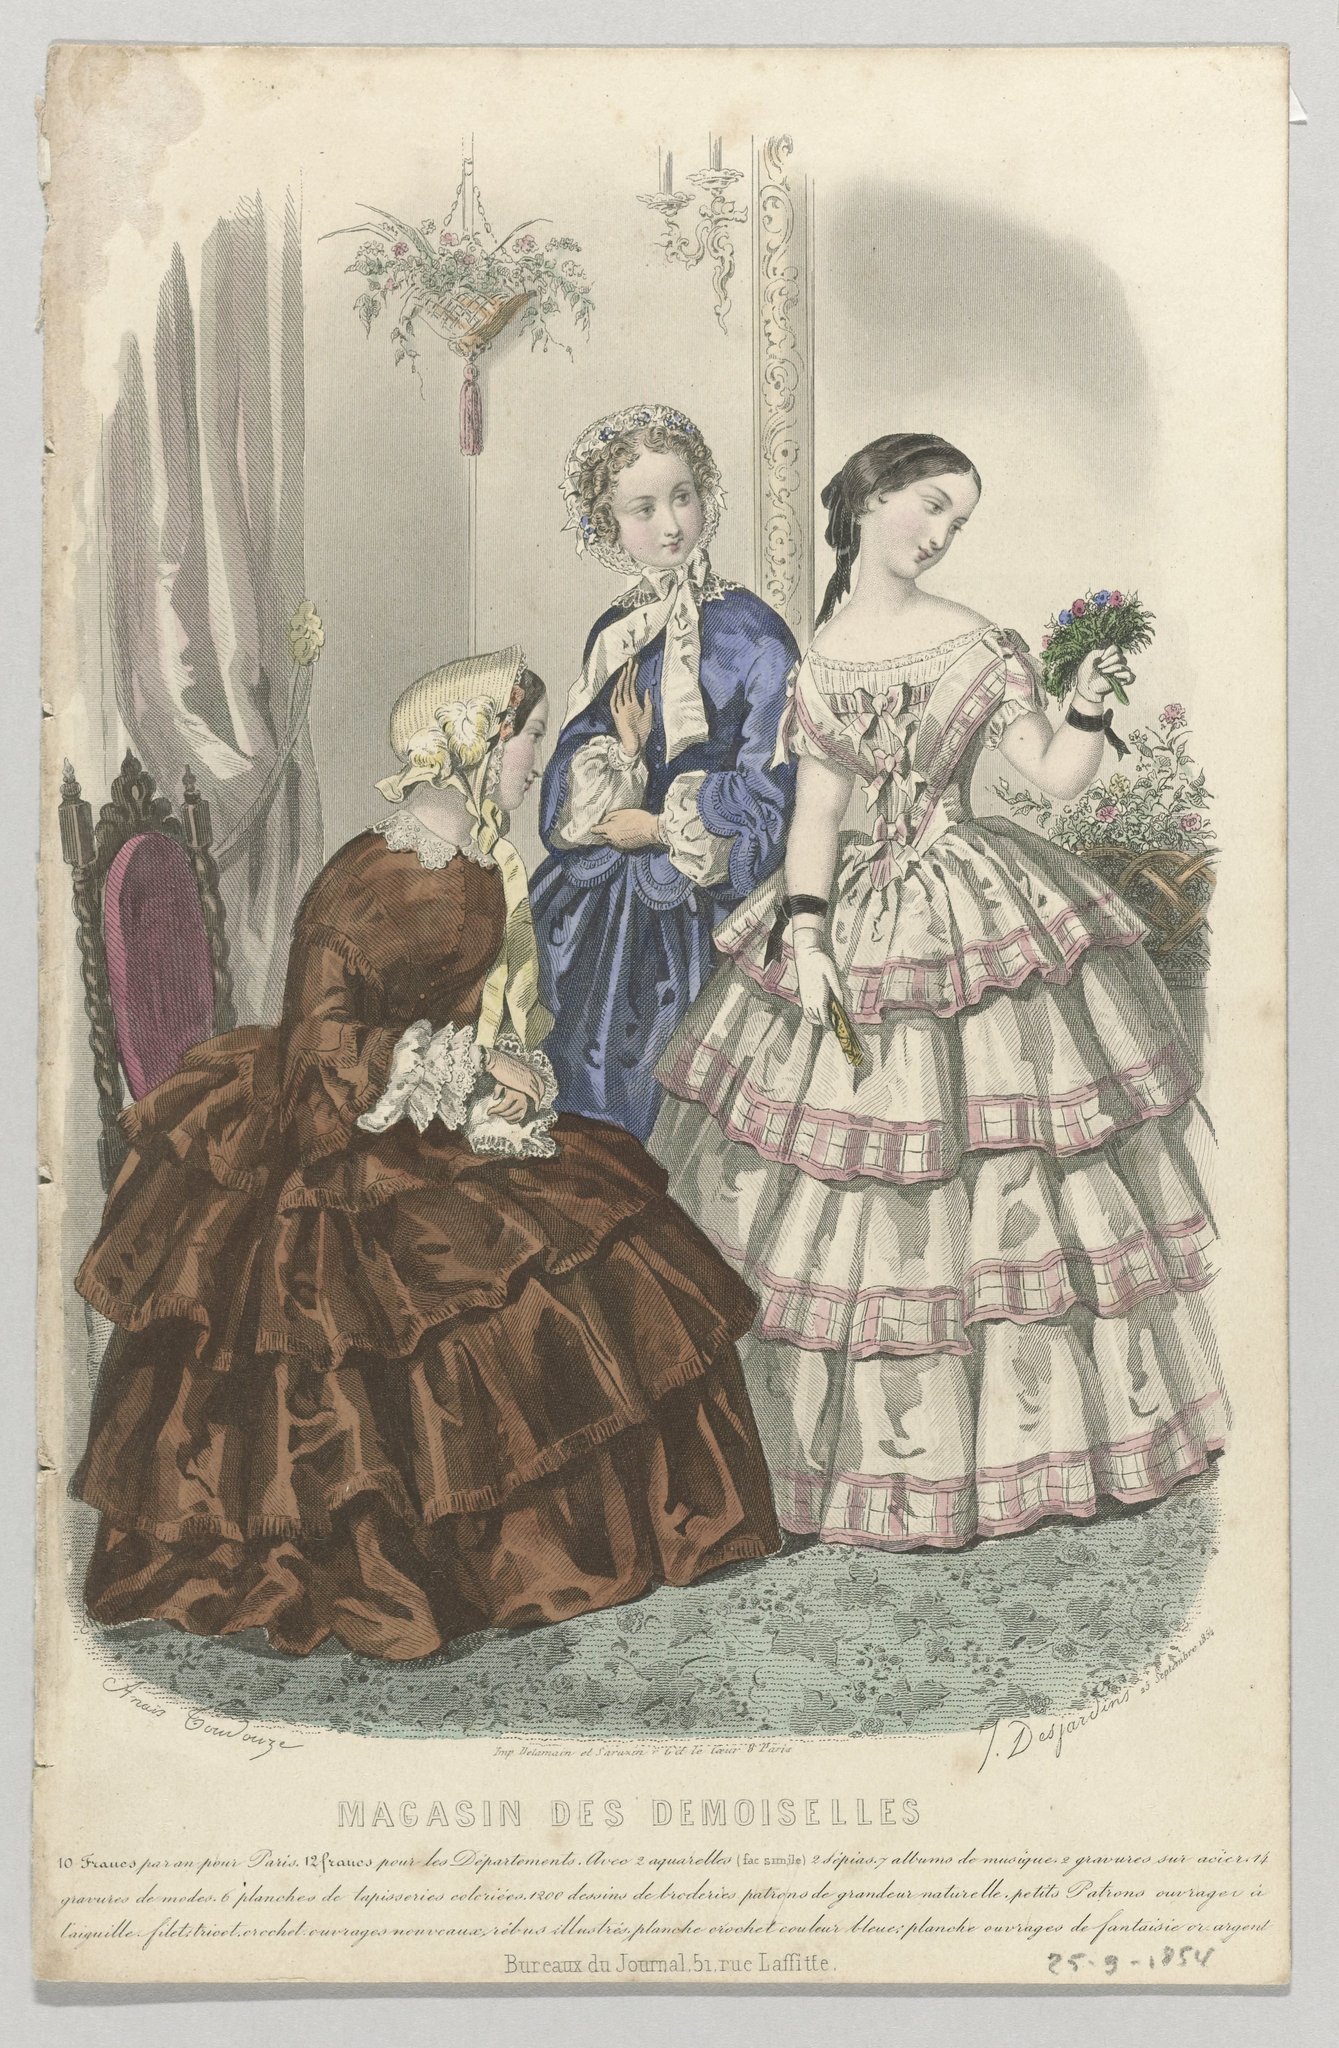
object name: fashion print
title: Magasin des Demoiselles, 25 septembre 1854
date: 1854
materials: paper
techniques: hand coloring, engraving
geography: paris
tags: bow (ornamental part of clothing) (+ women's clothes), handkerchief (+ women's clothes), cut flowers; nosegay, bunch of flowers, dress, gown: evening dress (+ women's clothes), gloves, mittens (short gloves) (+ women's clothes), fashion plates, head-gear: hat (+ women's clothes), fan (+ women's clothes), neck-gear ~ clothing (+ women's clothes), bracelet, wristlet (+ women's clothes)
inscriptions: caption: ‘10 Francs par an pour Paris 12 francs pour les Départements, Avec 2 Aquarelles (fac simile) 2 sepias, 7 albums de musique, 2 gravures sur acier, 14 gravures de modes, 6 planches de tapisseries coloriées, 1200 dessins de broderies, patrons de grandeur naturelle, petits patrons, ouvrages à l'aiguille, filet, tricot, crochet ouvrages nouveaux, rébus illustrés. planches crochet, couleur bleue: planche de petits ouvrages fantaisie or argent.’, title: ‘Magasin des Demoiselles’, address: ‘Bureaux du Journal, 51, rue Laffitte.’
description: Drie vrouwen in een interieur. Links: een bruine en een blauwe japon, hooggesloten en met wijd uitlopende mouwen en geplooide ondermouwen. Rechts: avondjapon met lichtroze strepenmotief. Puntig lijfje met boothals en korte mouwen, op de schouders versierd met strikken. Onder de voorstelling enkele regels informatie over het modetijdschrift. Prent uit het modetijdschrift Magasin des Demoiselles (1844-1896).